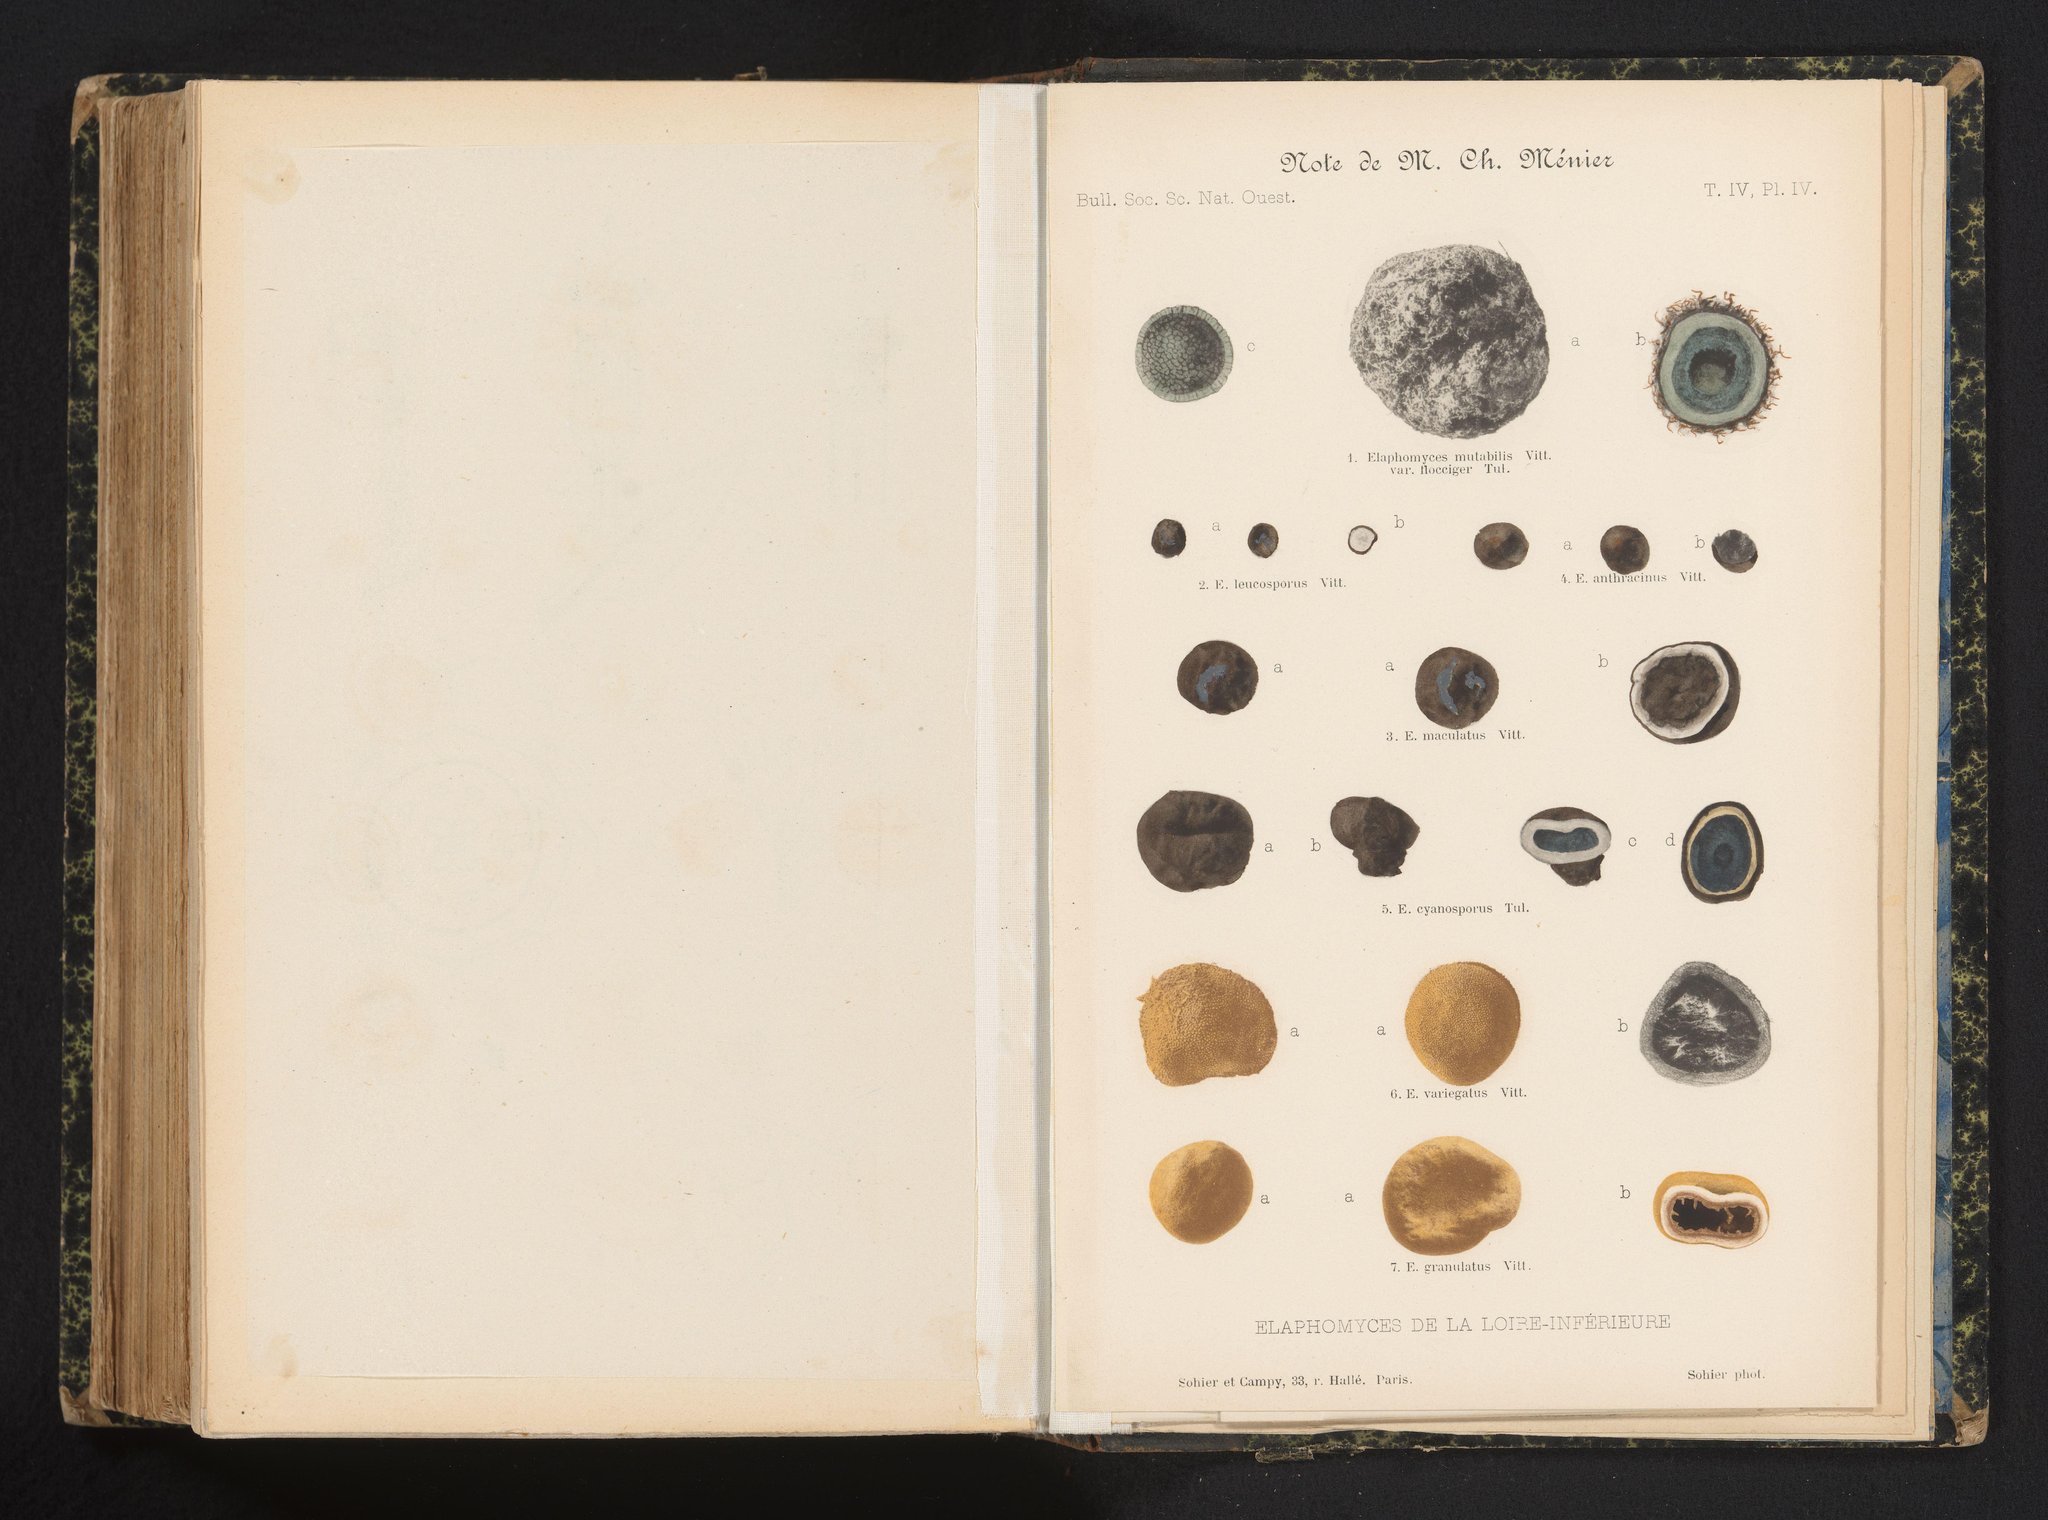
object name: photomechanical print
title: 22 voorbeelden van schimmels en doorsneden van schimmels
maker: sohier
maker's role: printer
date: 1888-1893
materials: paper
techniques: photograph, lithograph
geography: paris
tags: fungi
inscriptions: inscription: ‘Note de M. Ch. Ménier’, number: ‘T. IV, Pl. IV.’